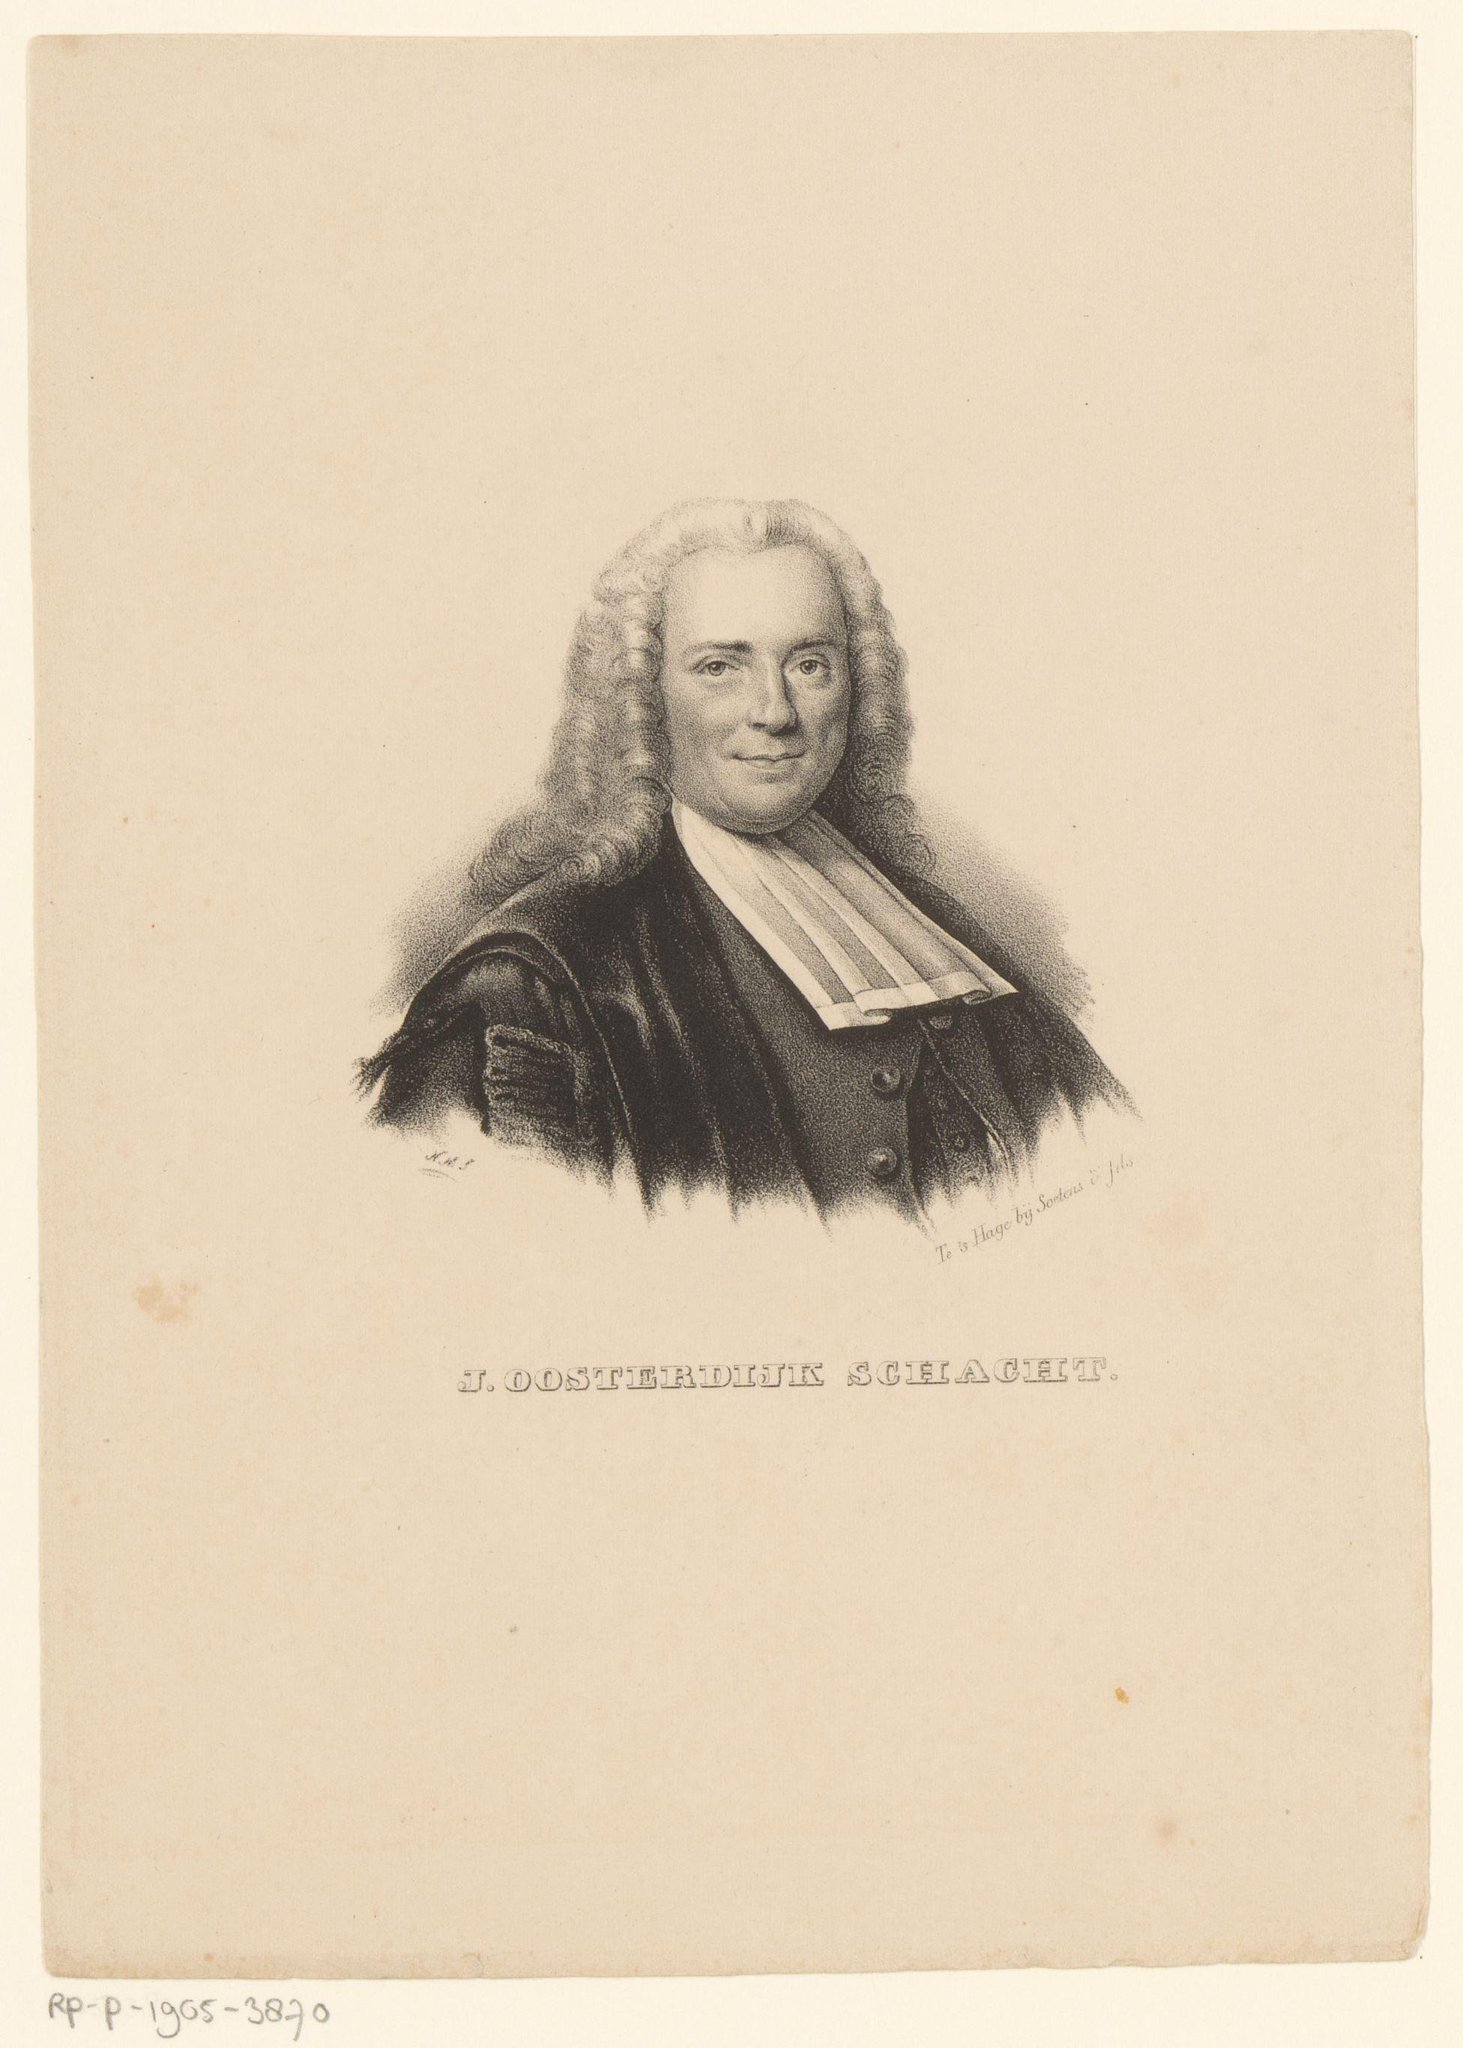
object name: print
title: Portret van Johannes Oosterdijk Schacht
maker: nicolaas martinus schild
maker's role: draughtsman, print maker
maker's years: 1822-1840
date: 1837-1840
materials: paper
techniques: lithograph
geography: the hague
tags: leiden, historical persons (+ (full) bust portrait)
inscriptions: collector's mark: Lugt 2228